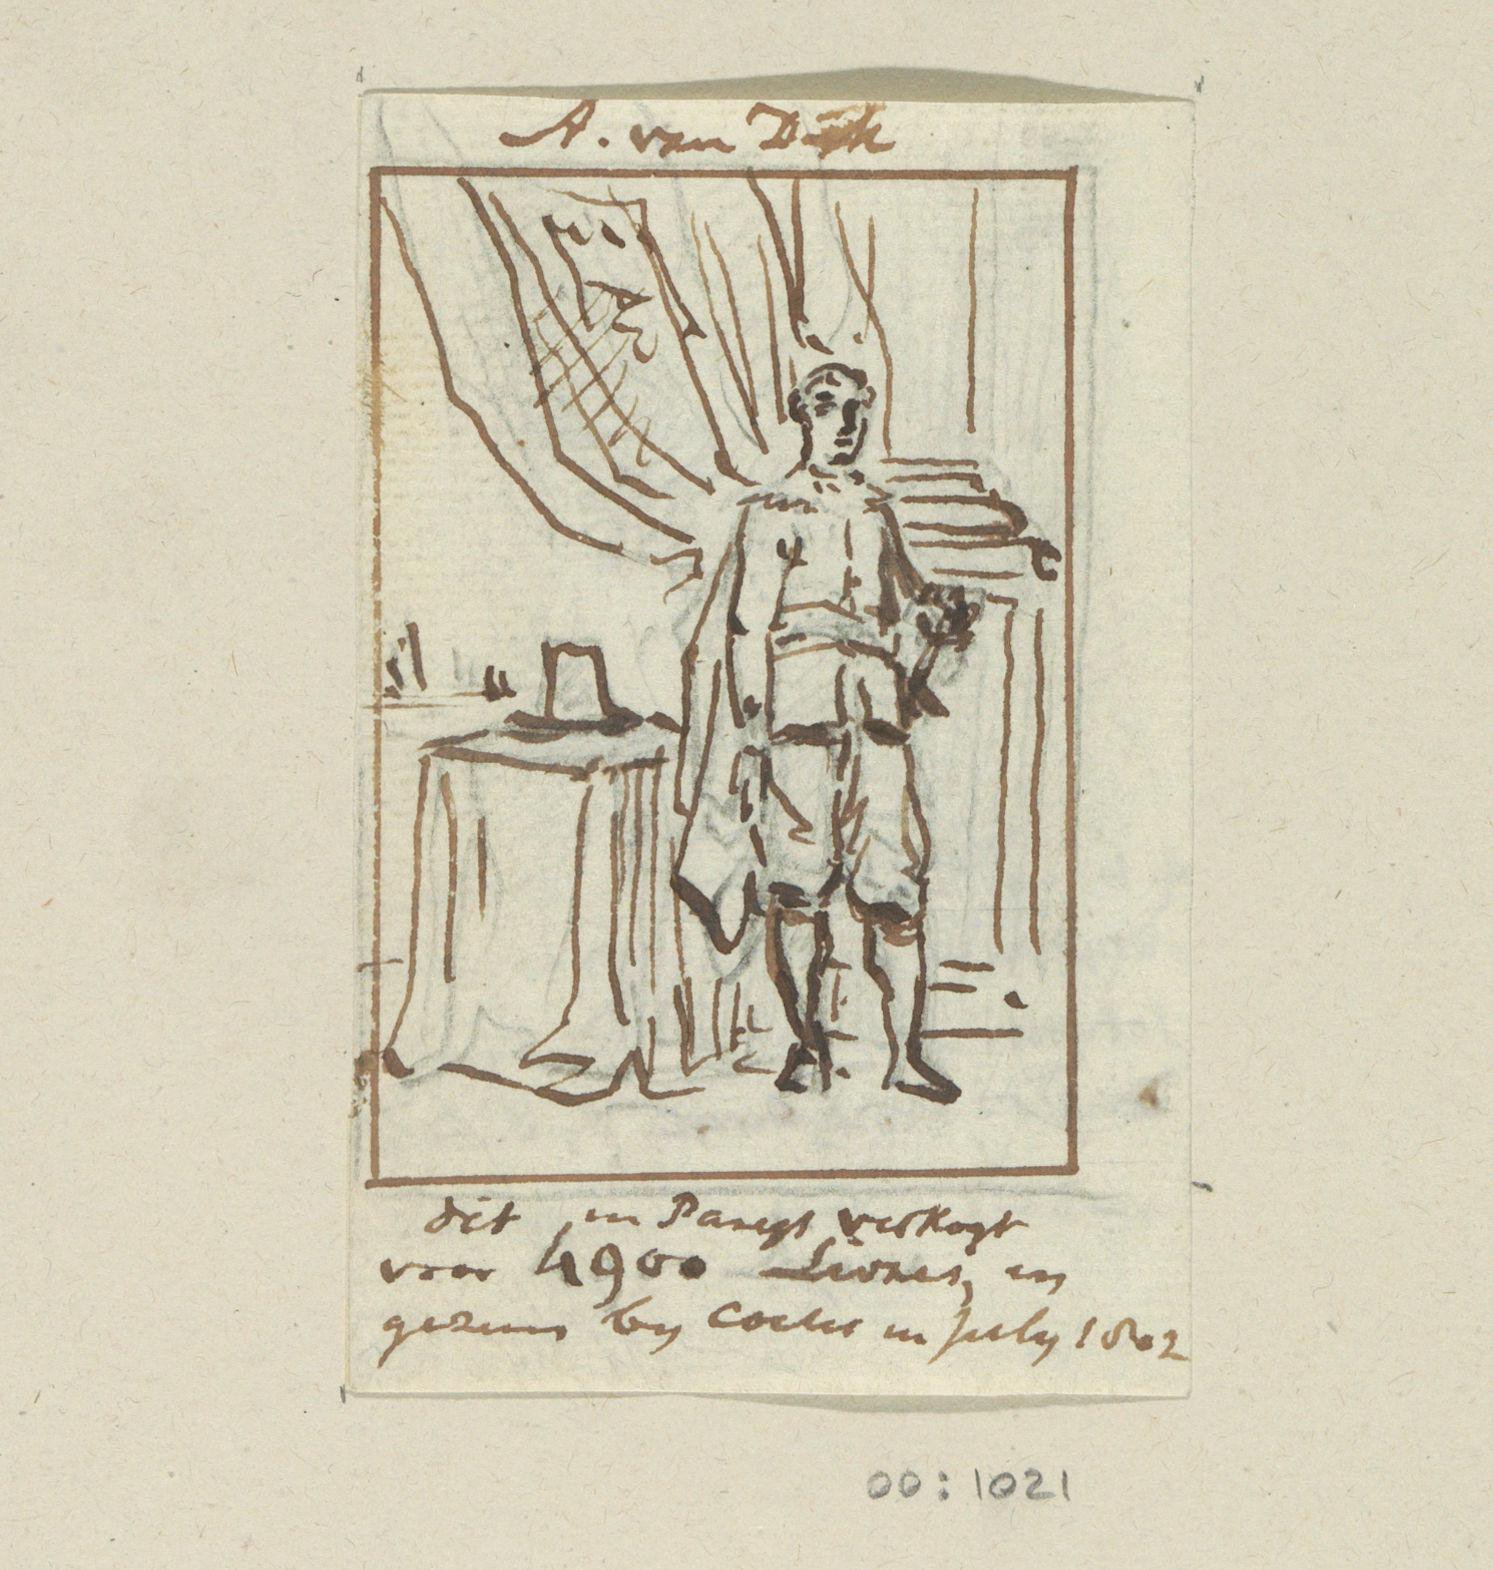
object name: drawing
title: Portret van een onbekende man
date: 1802-1819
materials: ink, paper, pencil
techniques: pen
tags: historical persons not known by name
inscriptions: inscription: ‘A. van Dyck/ dit in Parijs verkogt/ voor 4900 livres en/ gezien by co[...] in july 1802’, inscription: ‘[...]’